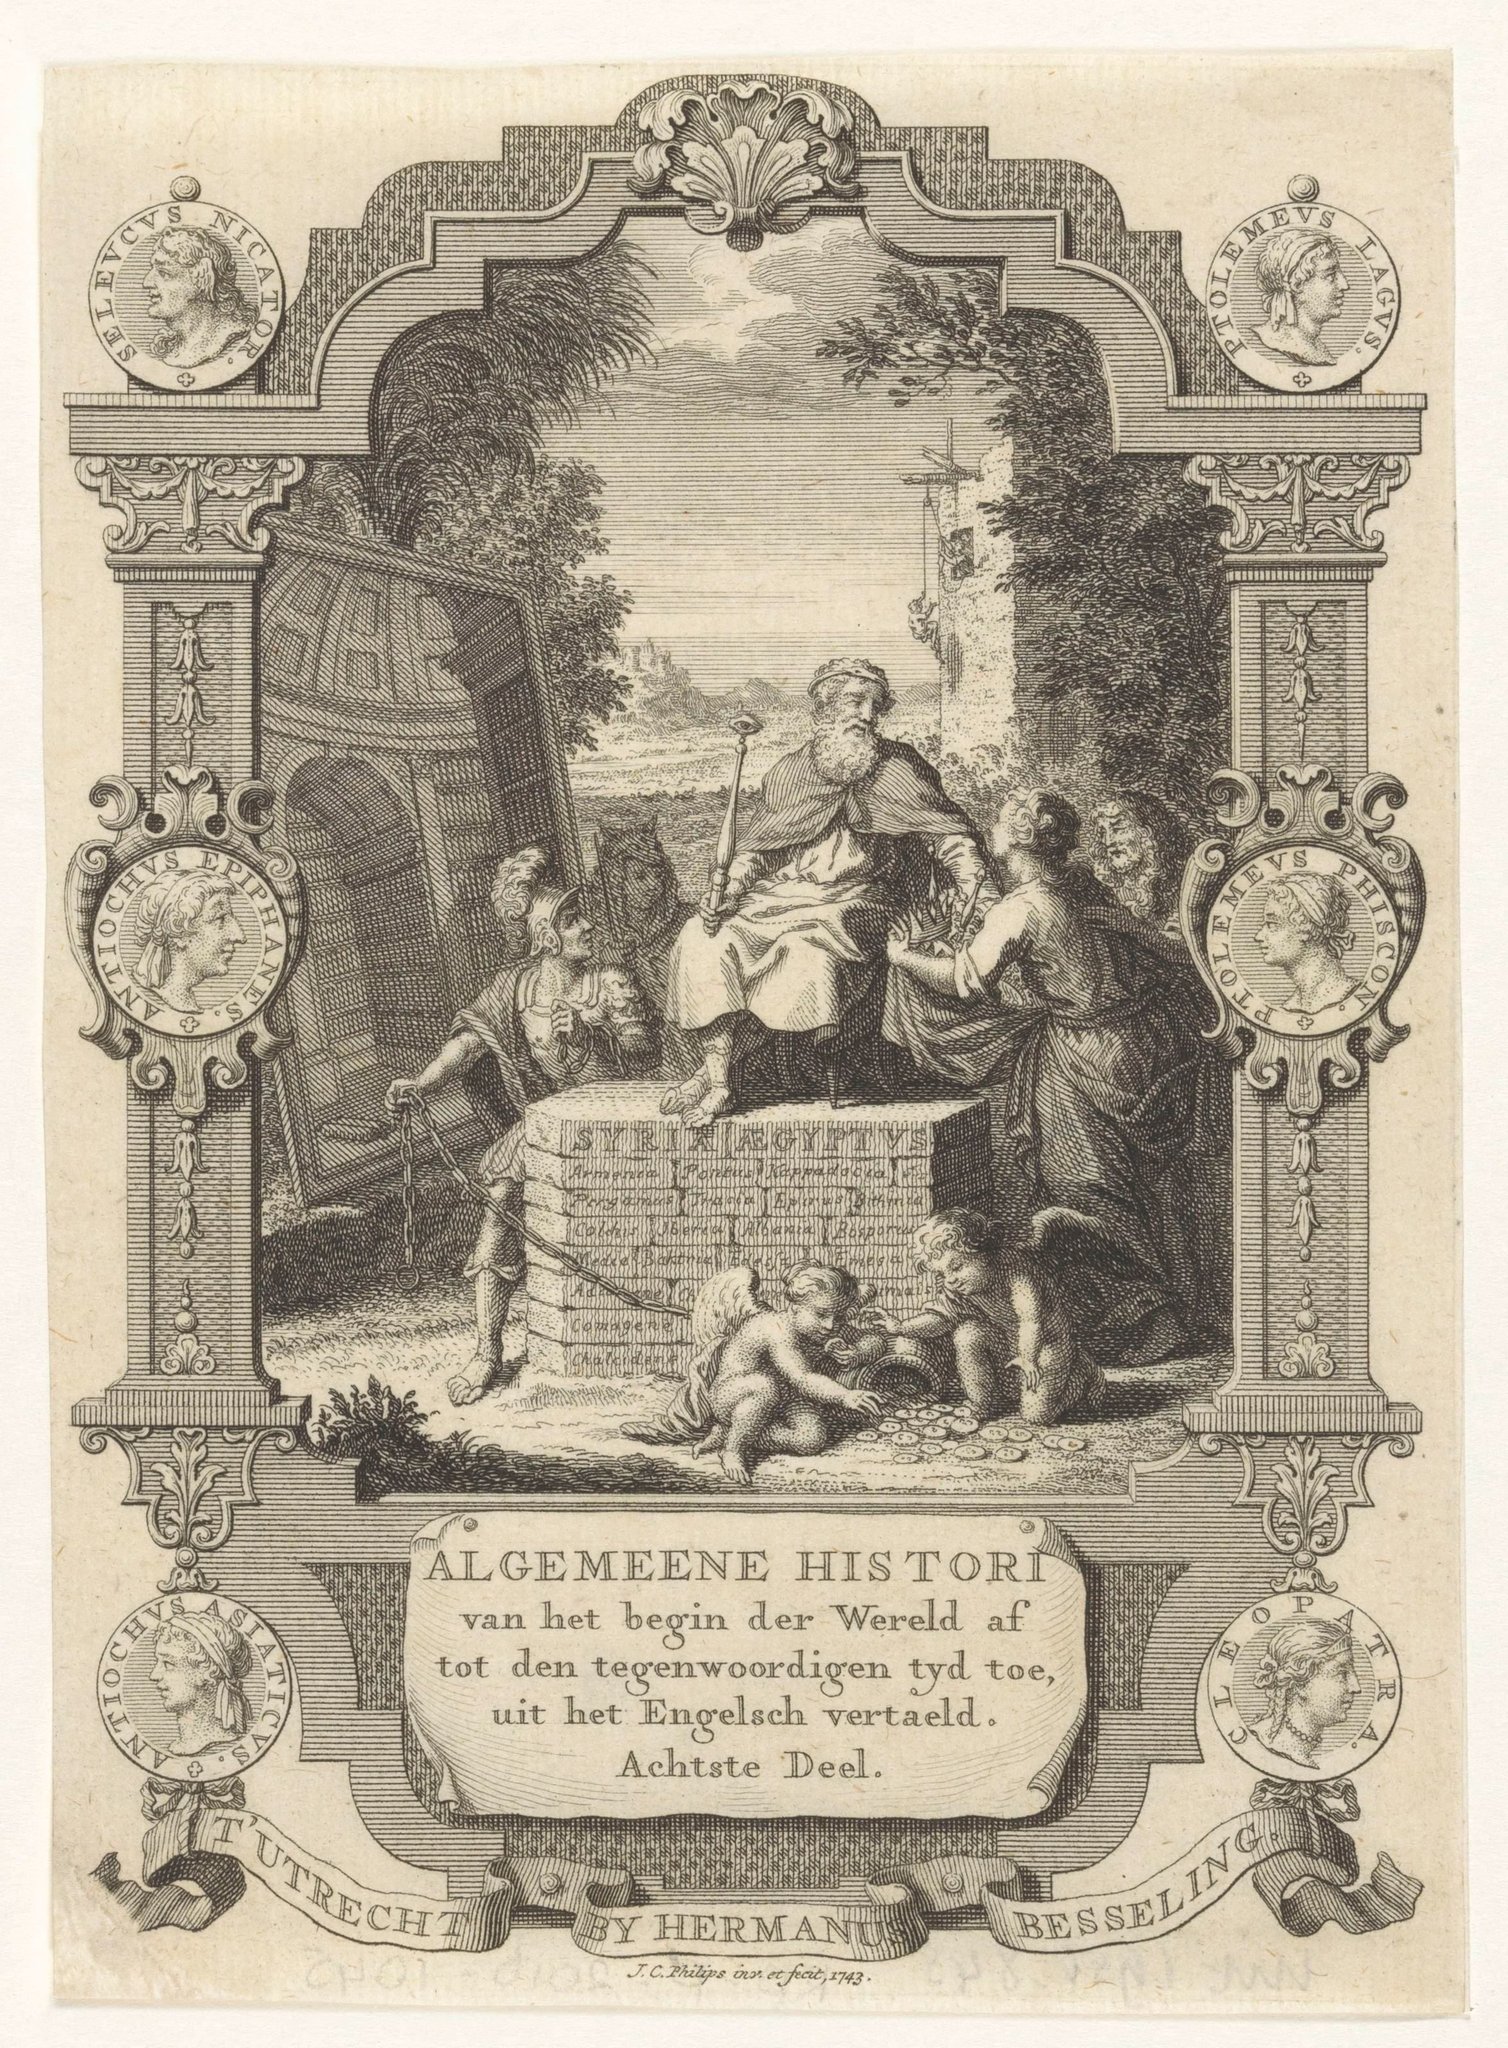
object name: titelblad, titelpagina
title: Cartouche met allegorie op de geschiedenis van Syrië en Egypte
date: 1743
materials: paper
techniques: engraving, etching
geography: amsterdam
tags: (story of) cleopatra - aggressive relationships of person from classical history (+ in allegorical or symbolic frame or setting; with allegorical or symbolic accessories), carefulness, diligence; 'diligenza' (ripa) (+ symbolical representation of concept), study; 'studiolo'; library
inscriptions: collector's mark: Lugt 2228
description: Een oude man tronend op een muur met in de hand een scepter met een oog, die symbool staat voor de waakzaamheid bij het staatsbestuur, krijgt een kroon aangereikt. Links een schilderij waarop de bibliotheek van de Ptolomeën. Rechts op de achtergrond een soldaat die in opdracht van Octavius het huis van Cleopatra inklimt. In de omlijsting van de cartouche medaillons met portretten van Ptolemeus en Seleucus.